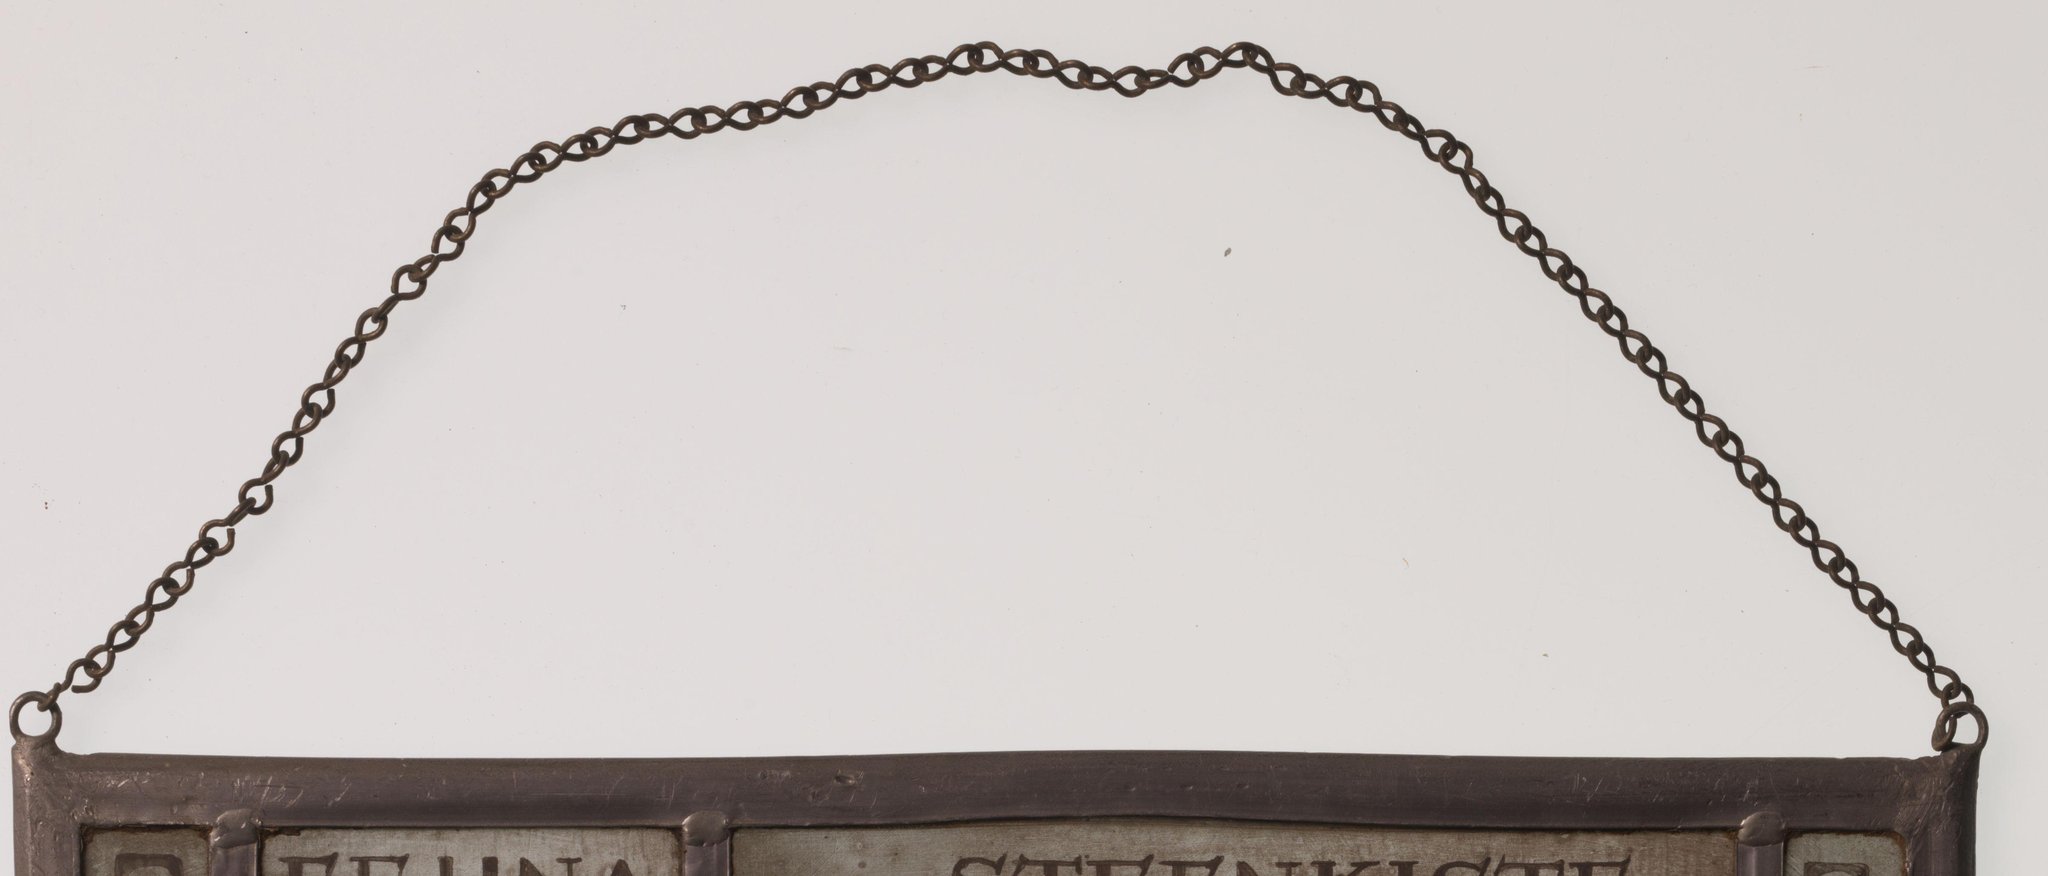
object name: light window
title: Glas-in-loodruit met het portret van Feyntje van Steenkiste (1603-1640)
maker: Anonymous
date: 1635-1900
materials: glass, lead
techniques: leading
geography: haarlem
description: Glas-in-loodruit met het portret van Feyntje van Steenkiste (1603-1640). Kopie naar het schilderij van Frans Hals in het Rijksmuseum.